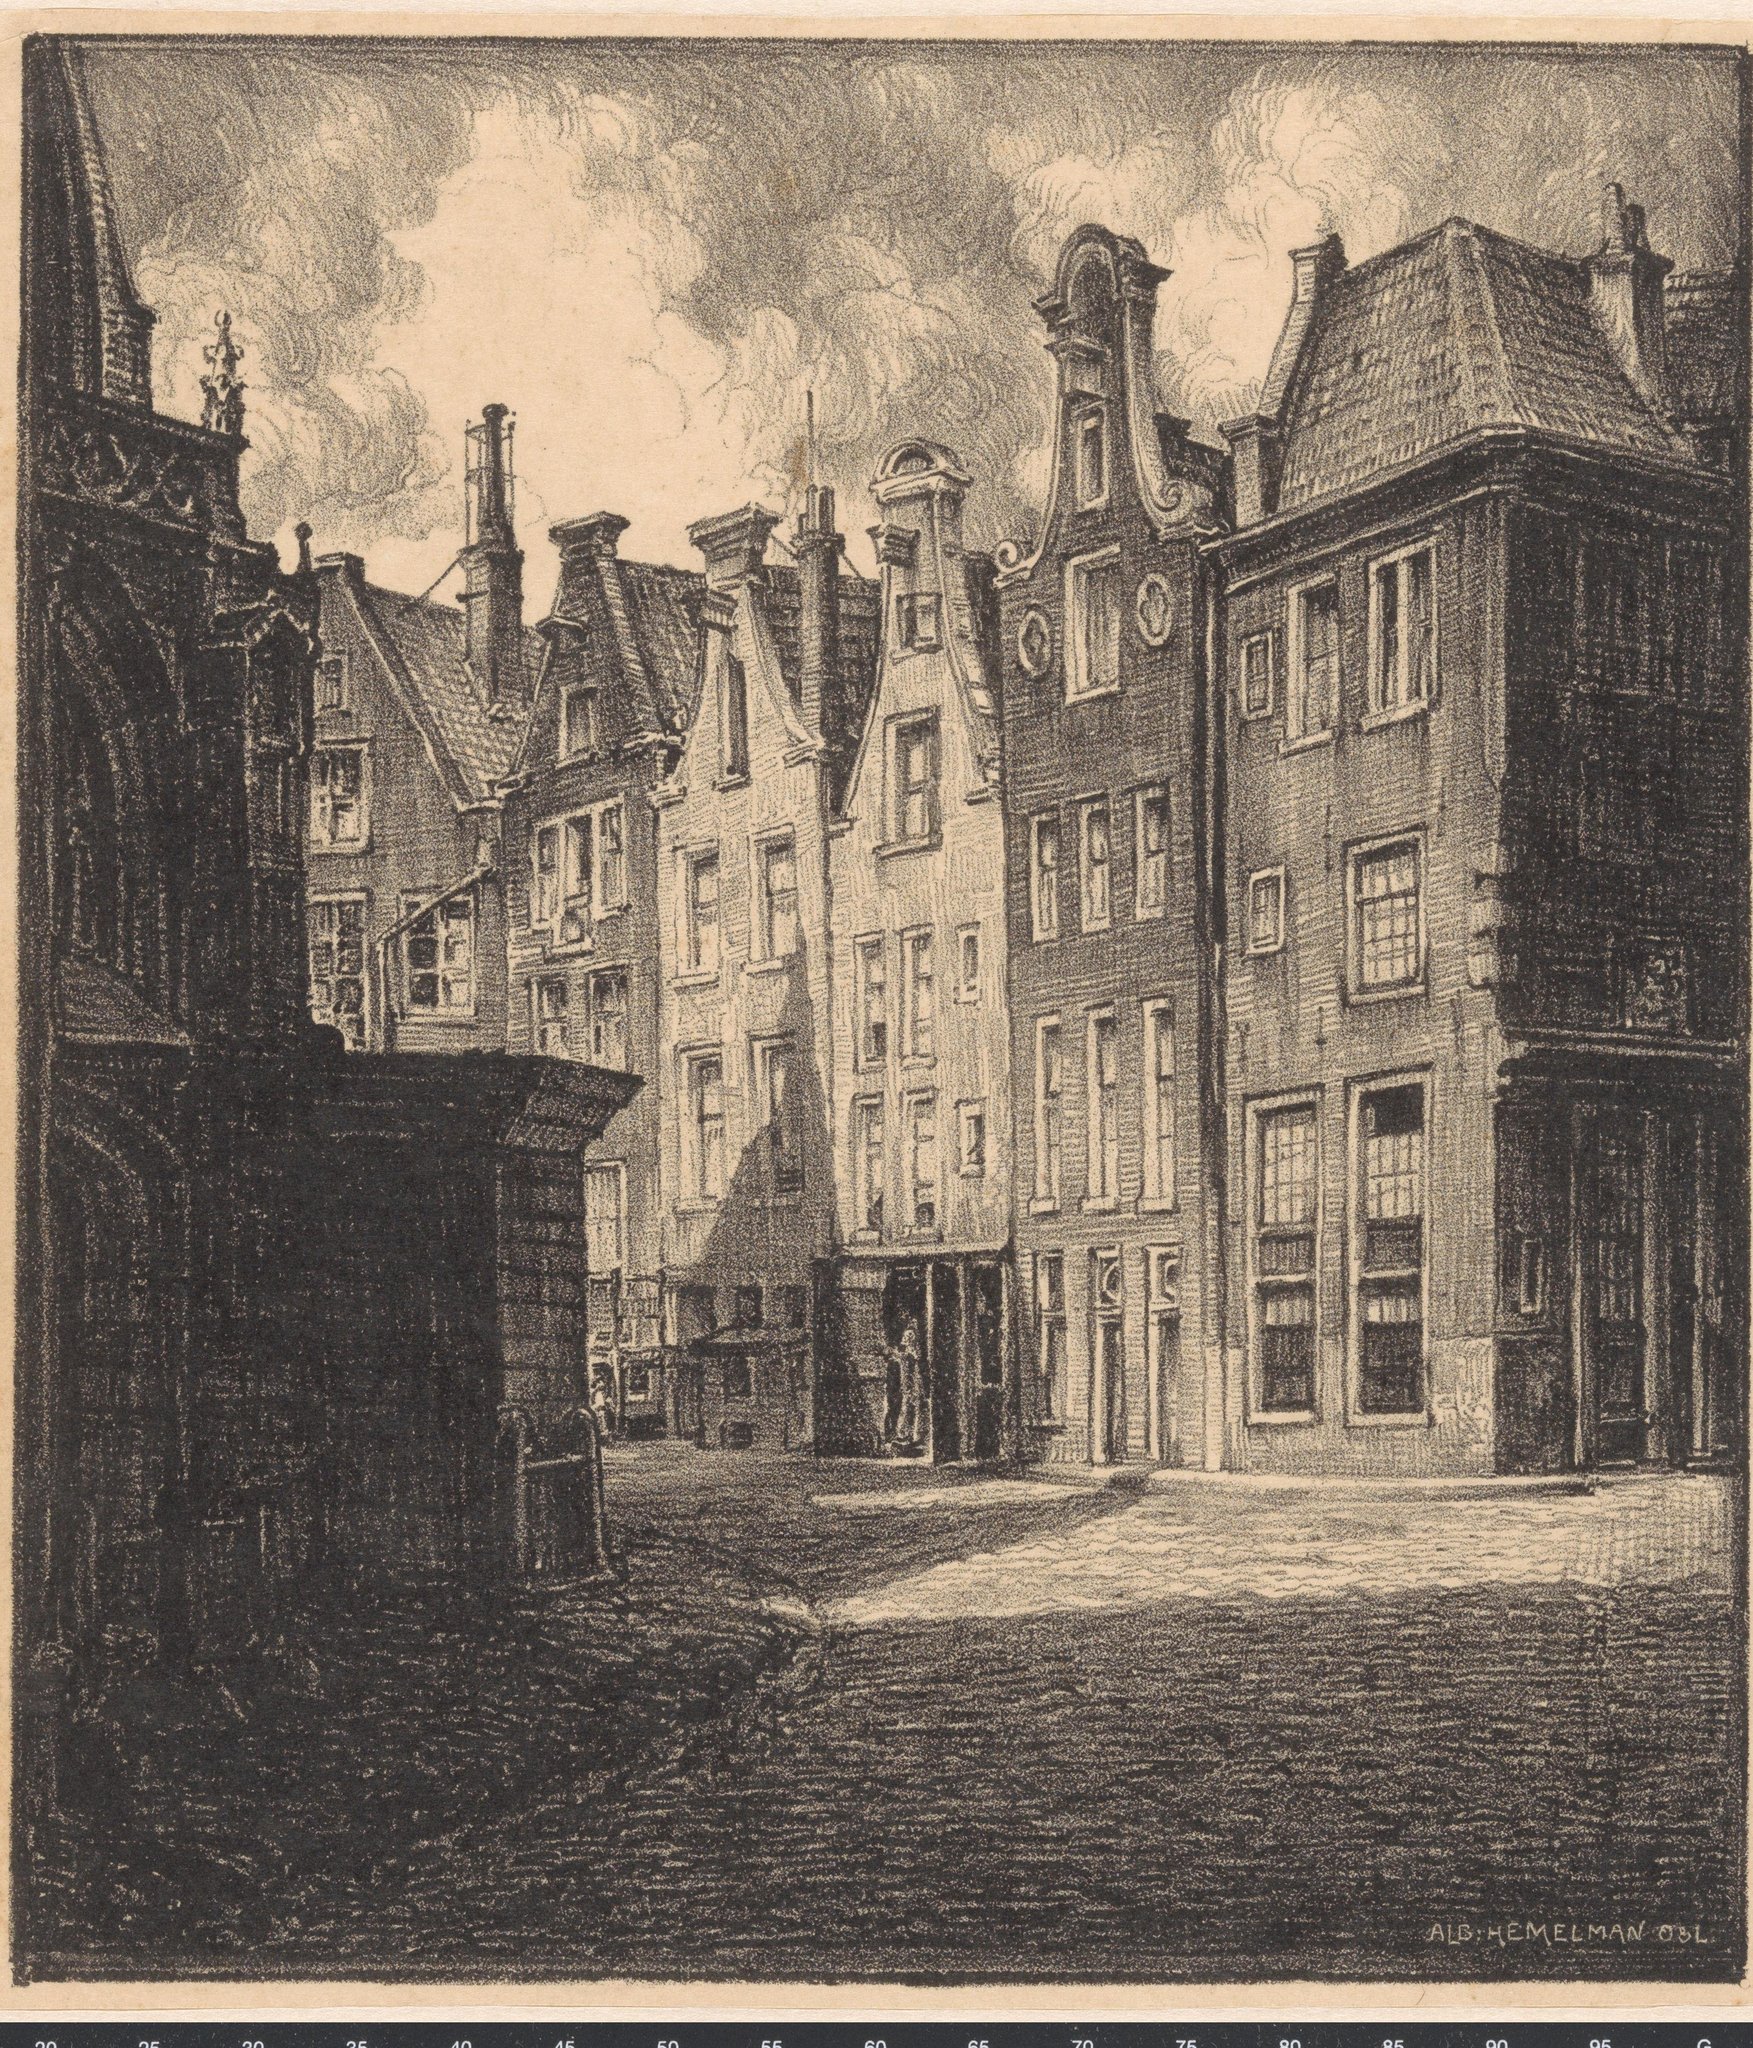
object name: print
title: Oude Kerksplein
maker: albert hemelman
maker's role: draughtsman, print maker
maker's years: 1883-1951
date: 1902-1951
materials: paper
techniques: lithograph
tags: city-view in general; 'veduta' (+ city(-scape) with figures, staffage)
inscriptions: signature: ‘ALB :HEMELMAN 03L’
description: Een gedeelte van de Oude Kerk gehuld in schaduw links op de voorgrond, rechts enkele gevels badend in het licht.